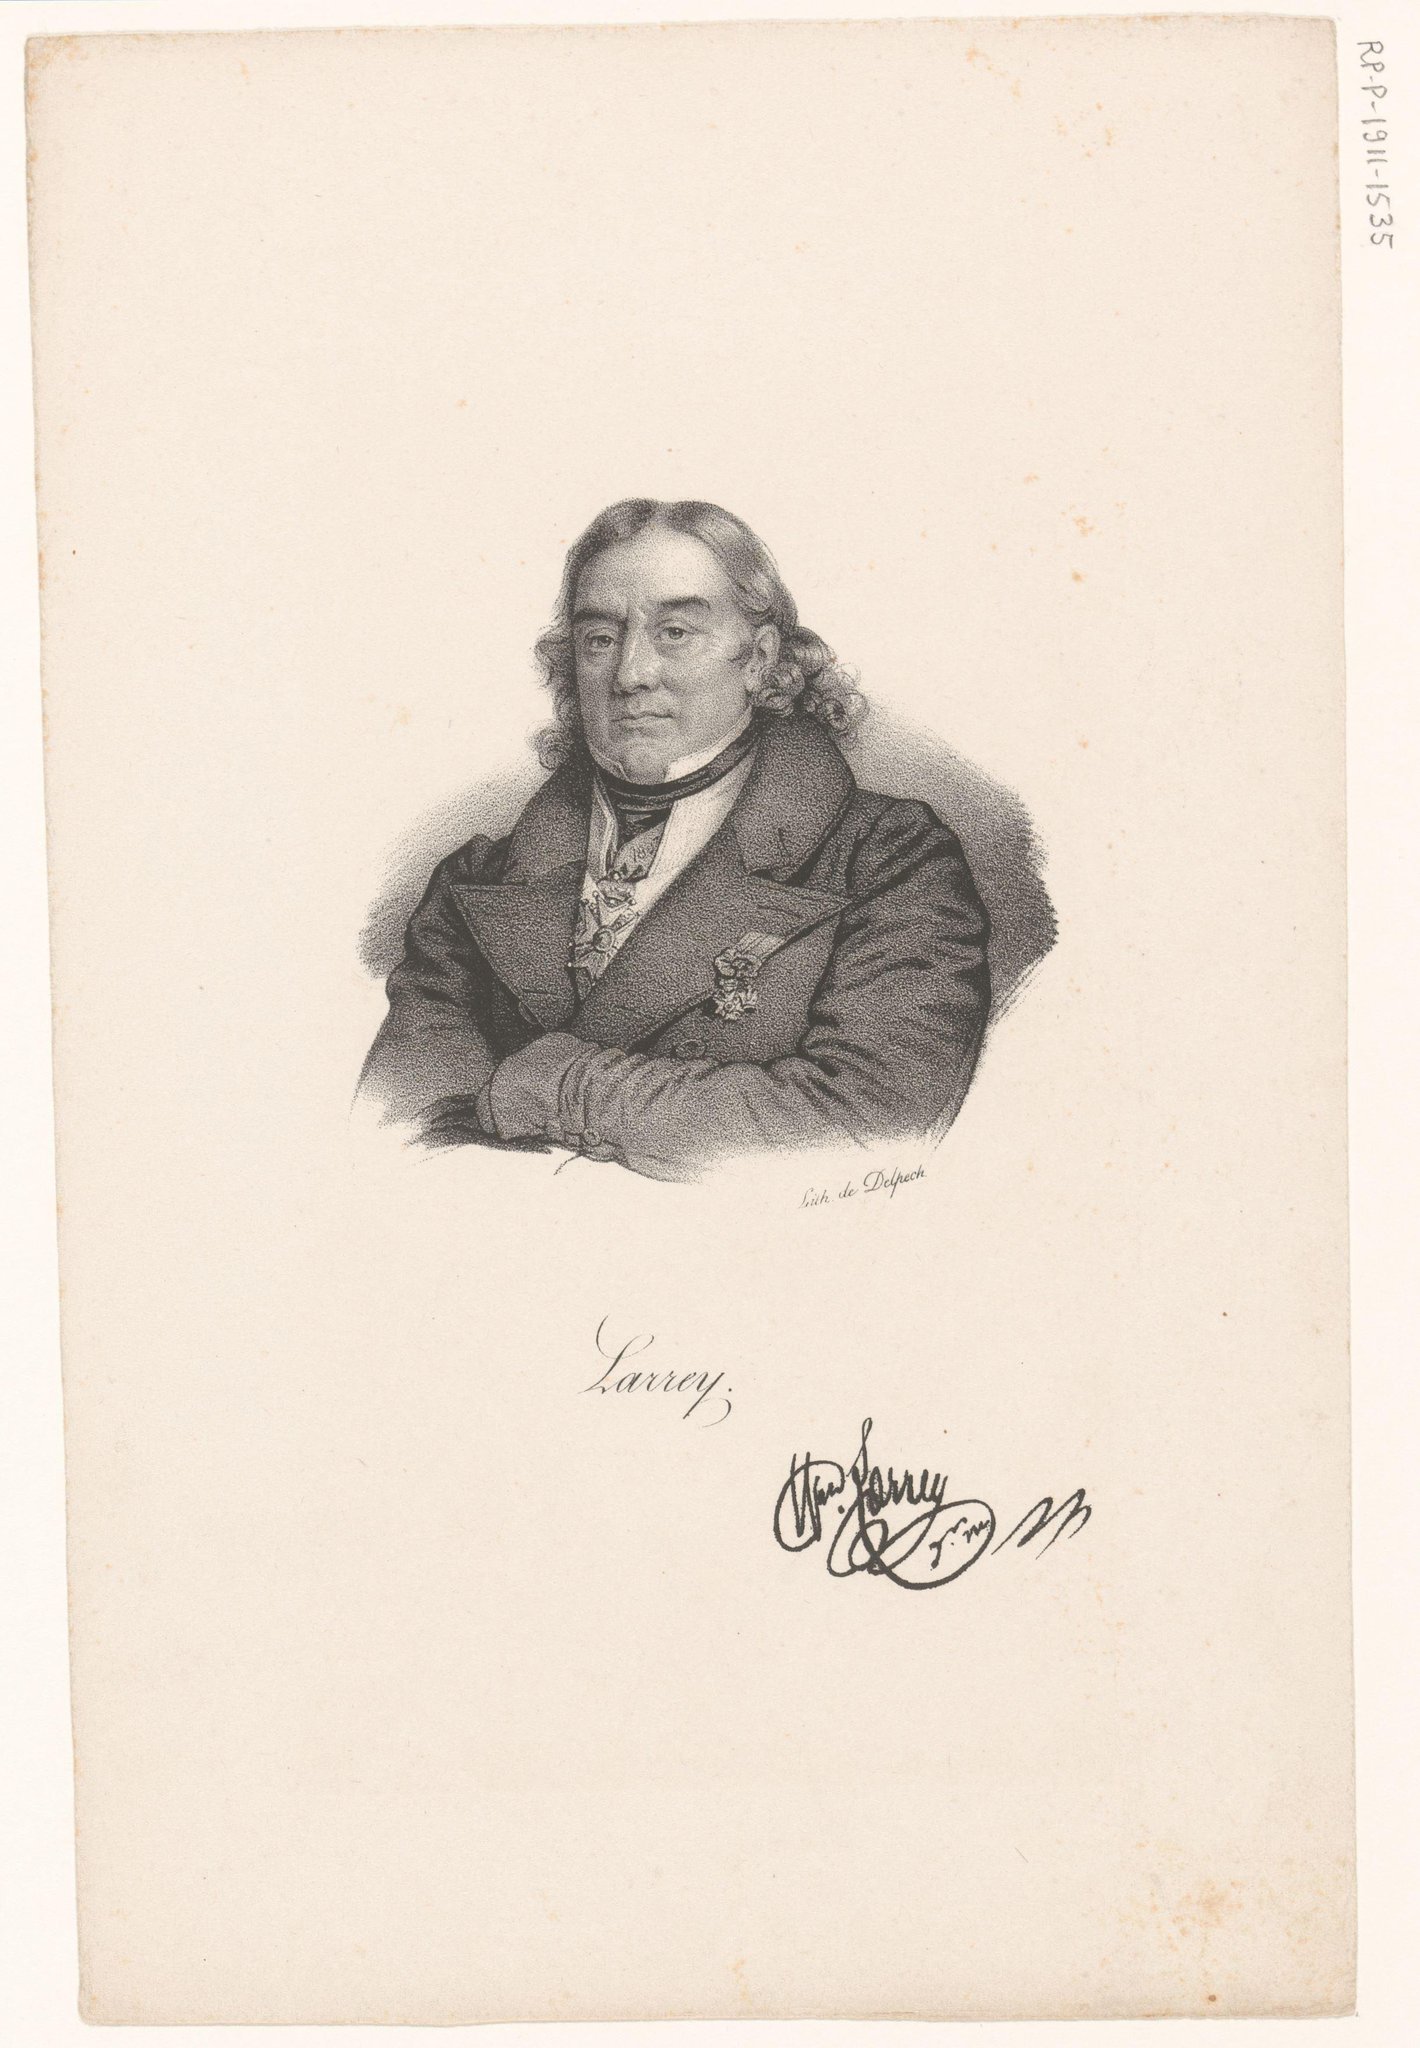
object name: print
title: Larrey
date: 1818-1842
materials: paper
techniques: lithograph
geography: paris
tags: lyon, historical persons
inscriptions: collector's mark: Lugt 2228a